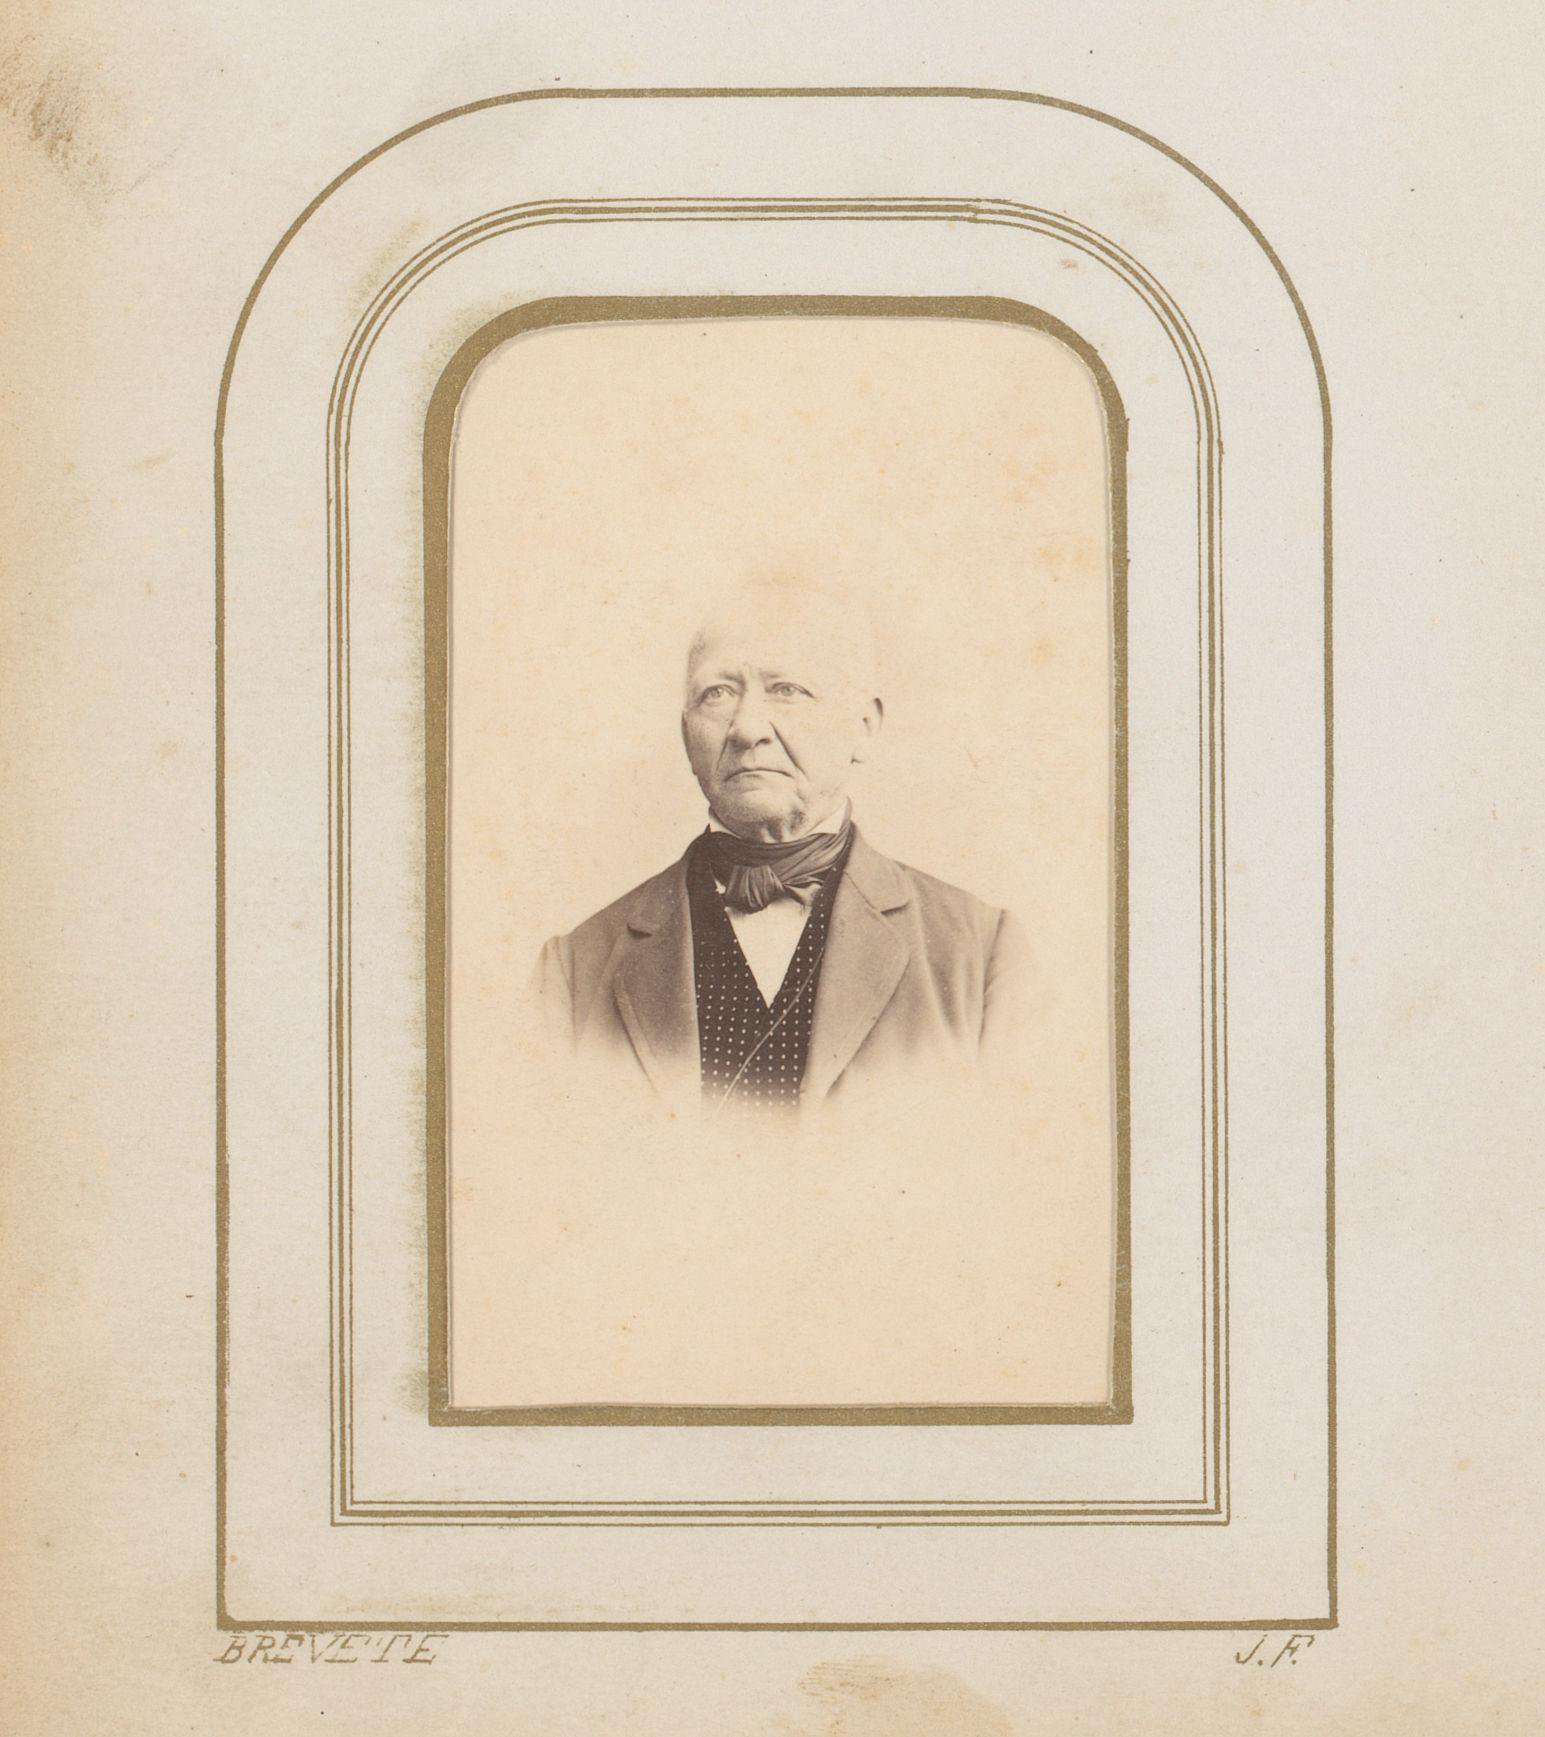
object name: photograph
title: Portret van een oude man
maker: p. brandebourg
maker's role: fotograaf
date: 1870-1880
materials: cardboard, photographic support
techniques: albumen print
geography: luxembourg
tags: historical persons, old man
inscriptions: inscription: ‘P. Brandebourg/ Photographie et Peinture/ Luxembourg/ descente de Clausen/ No.5’